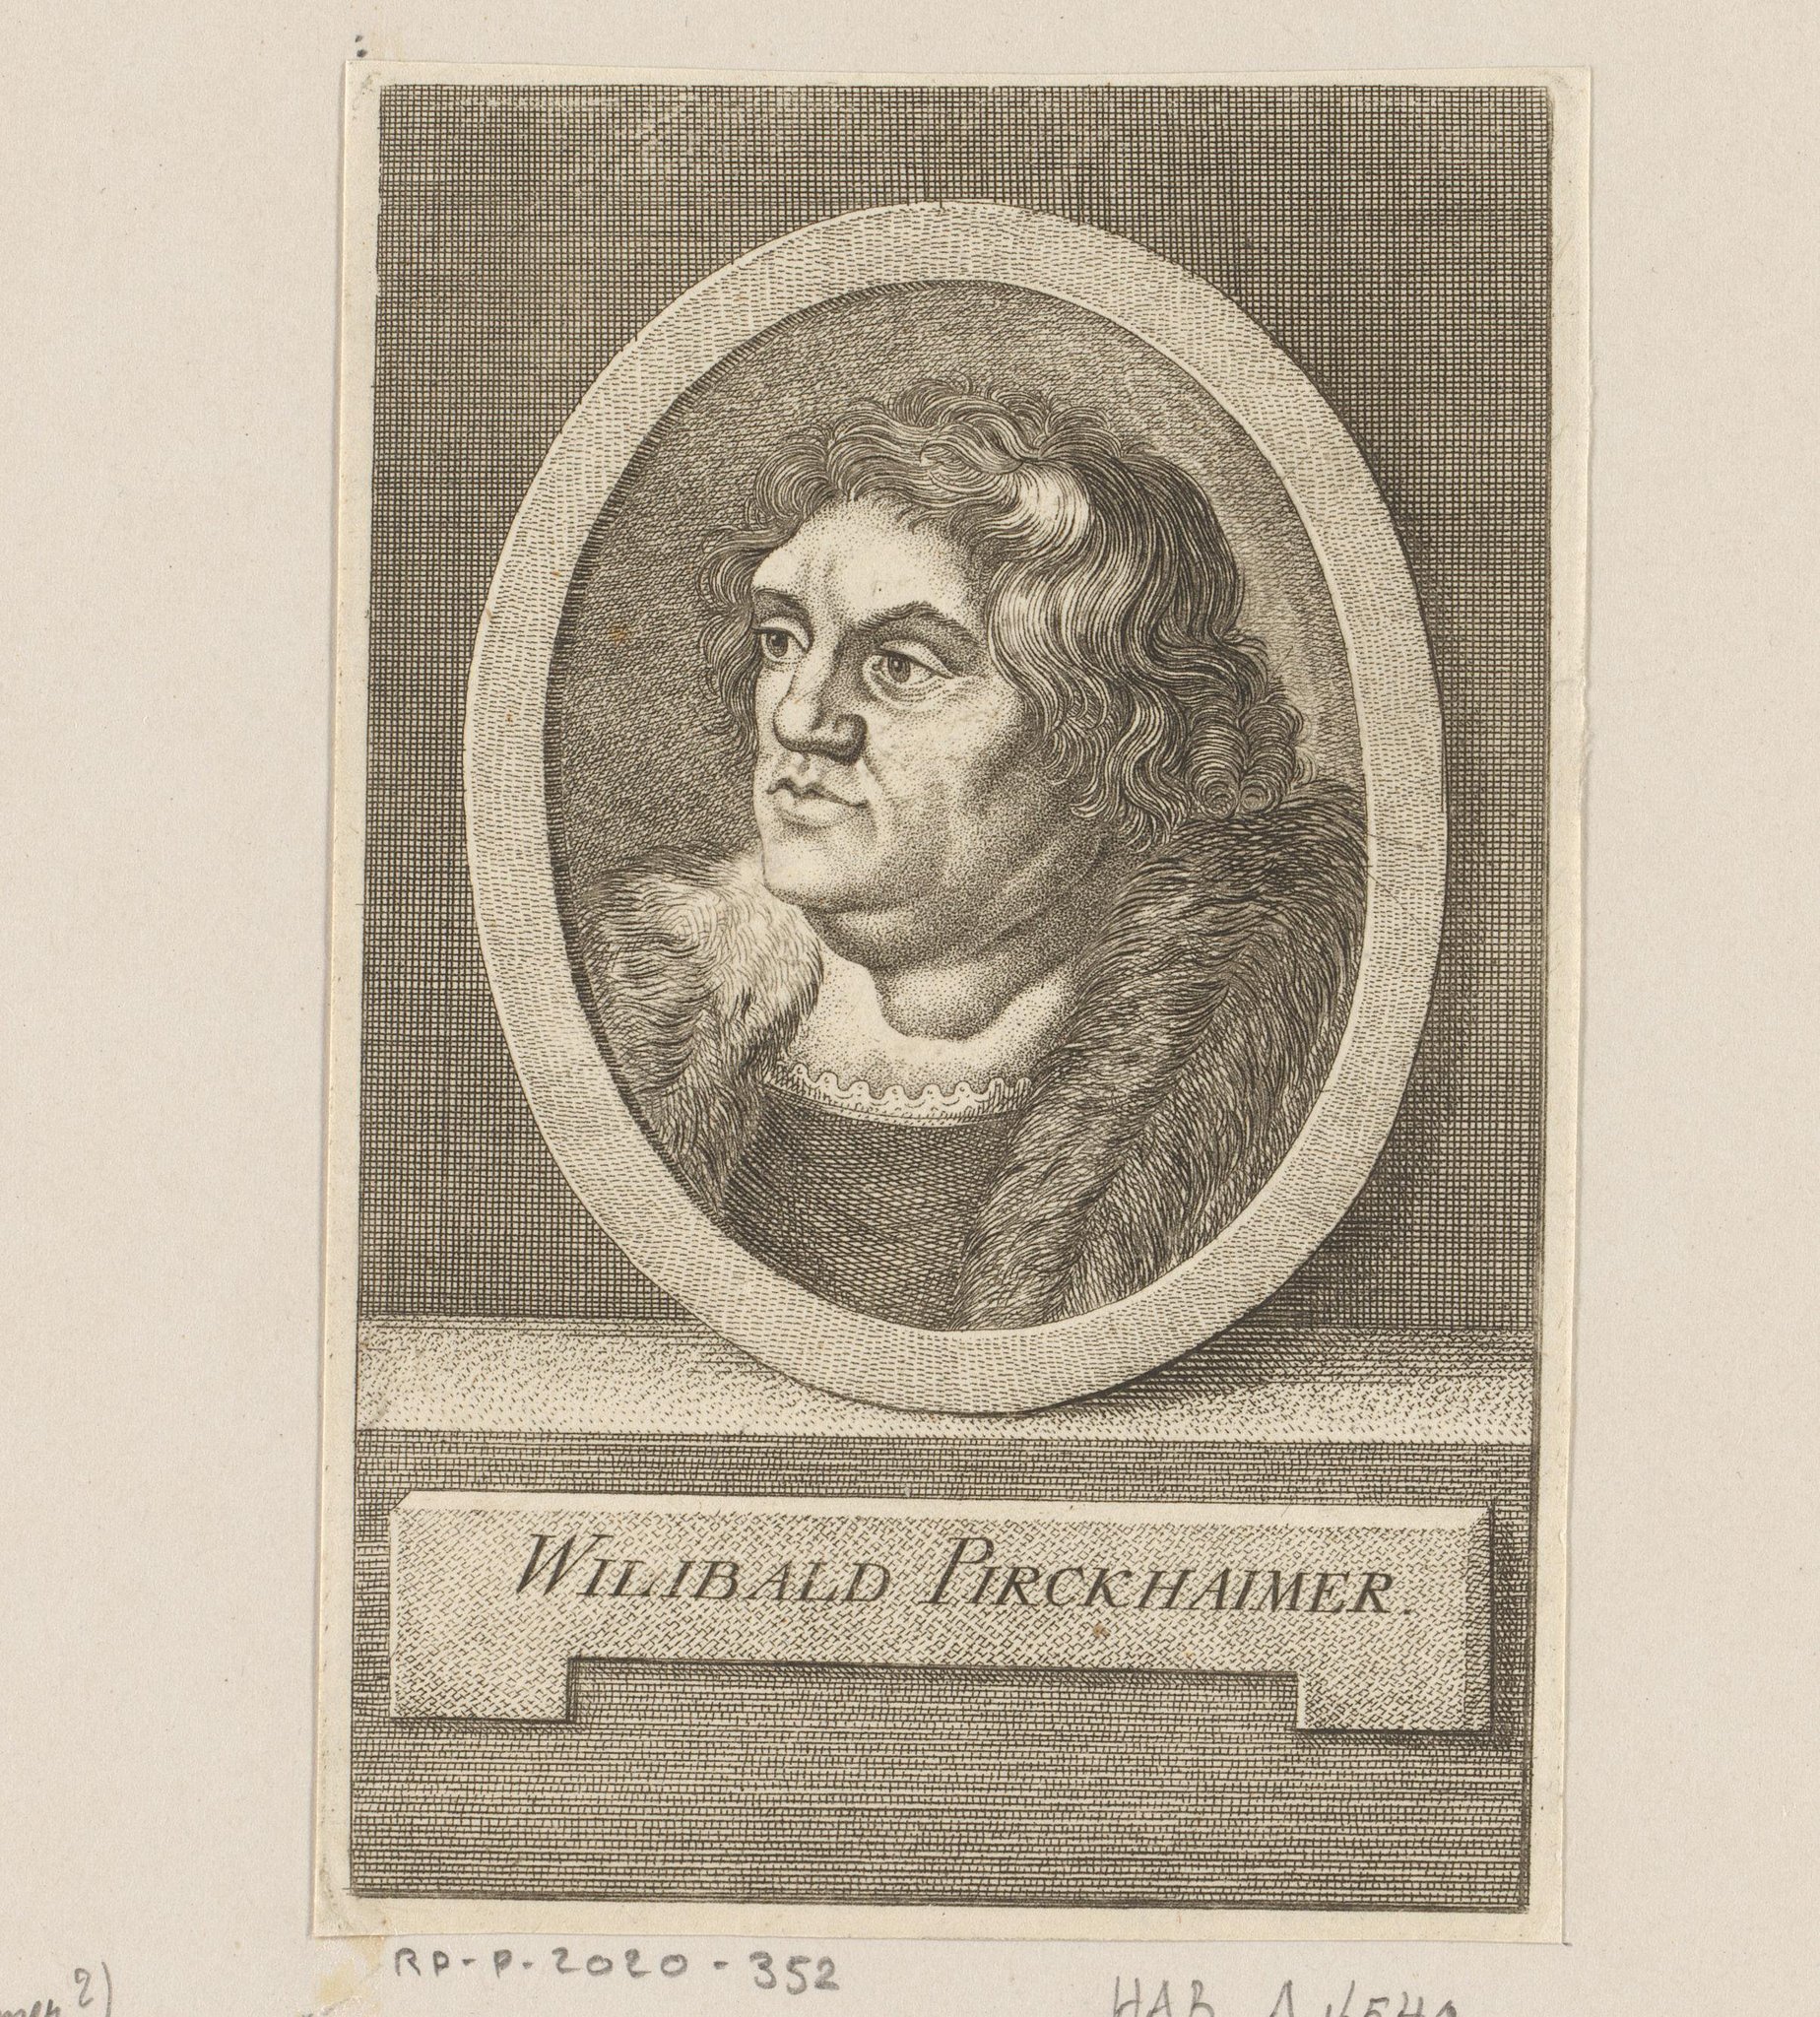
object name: print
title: Wilibald Pirckhaimer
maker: Anonymous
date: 1776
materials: paper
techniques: engraving, etching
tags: eichstätt, willibald pirckheimer, historical persons, portrait of a writer, book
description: Prent gebruikt in: Der teutsche Merkur (...) Junius 1776. S.l.s.n., 1776.